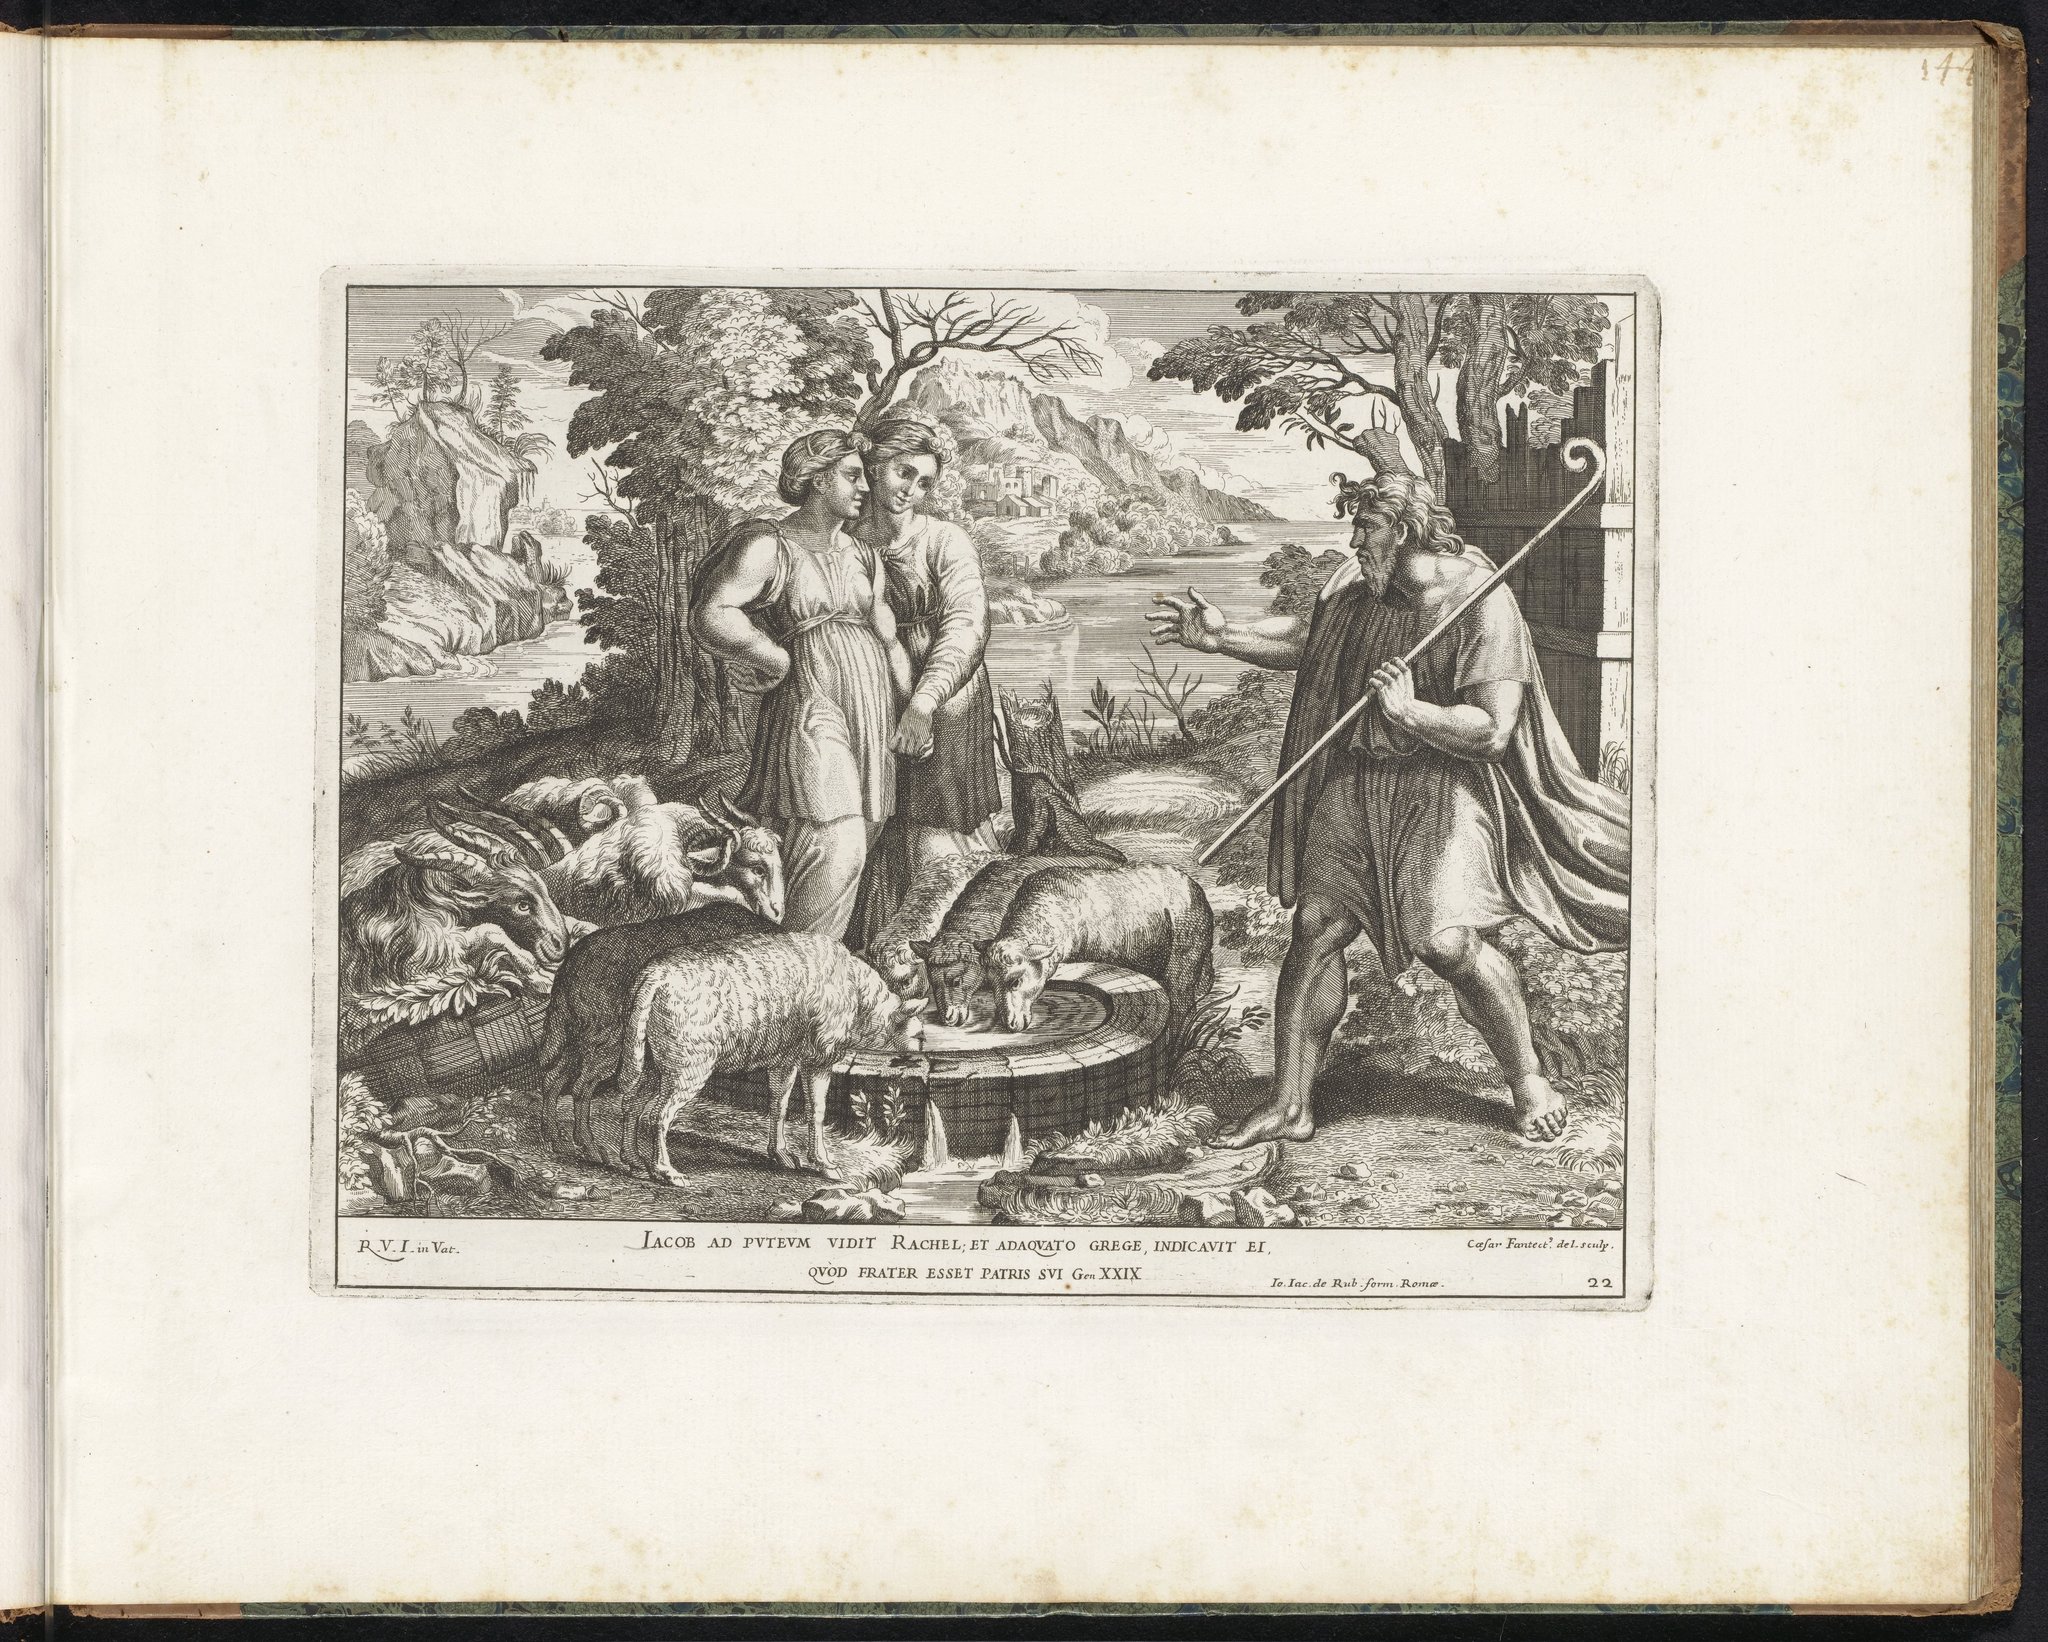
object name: print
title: Rafaël Bijbel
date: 1675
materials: paper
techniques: etching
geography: italy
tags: jacob at the well of haran (genesis 29:1-13)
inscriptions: number: ‘144’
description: Rachel laat de kudde schapen en geiten van haar vader drinken bij een bron. Bij de bron ontmoeten Rachel en Jakob elkaar. Bijbelvers onder de voorstelling. Prent maakt deel uit van een album.